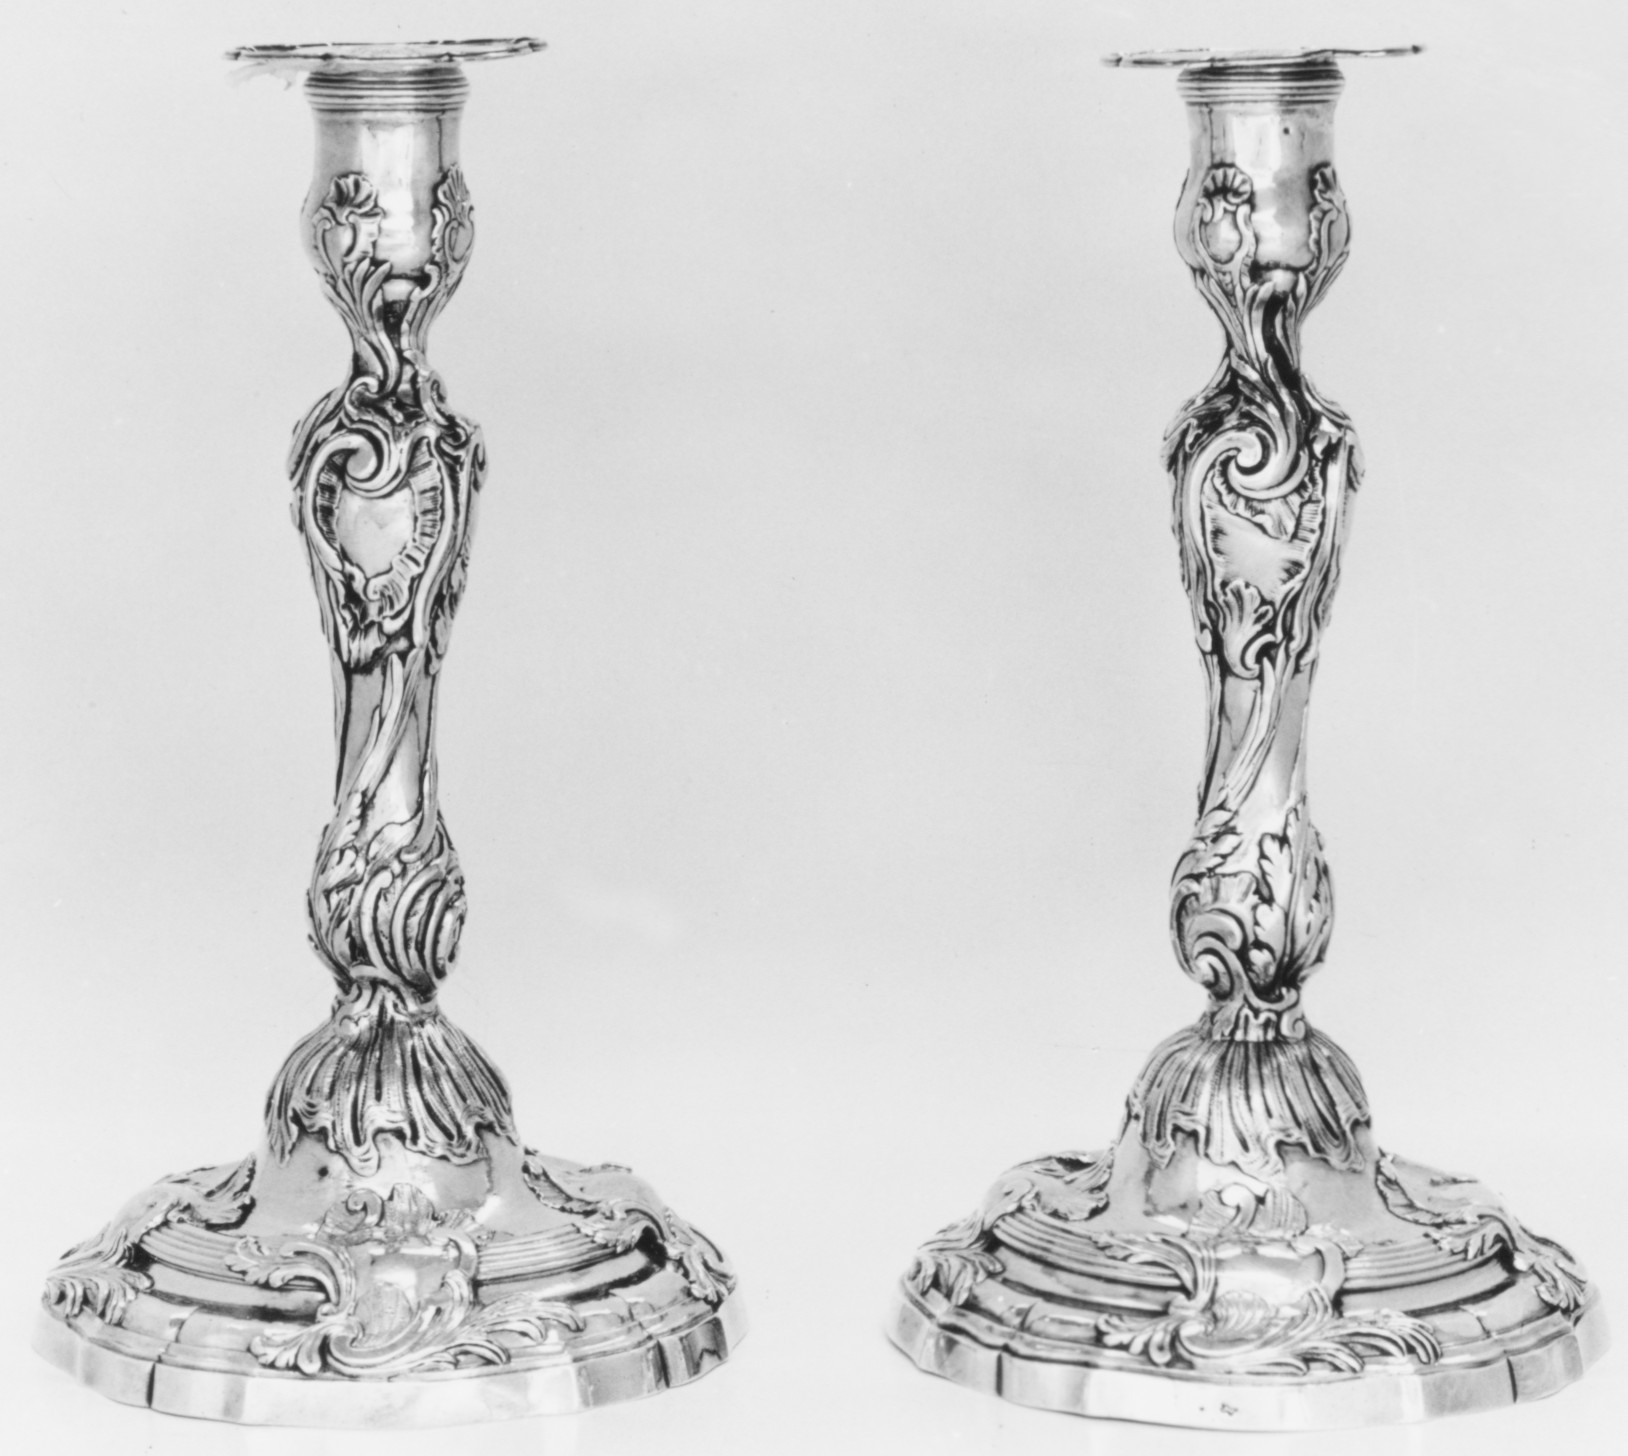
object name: candlestick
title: Candlestick (one of a pair)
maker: michel ii delapierre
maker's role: maker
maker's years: 1707-1815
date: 1747-1749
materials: silver